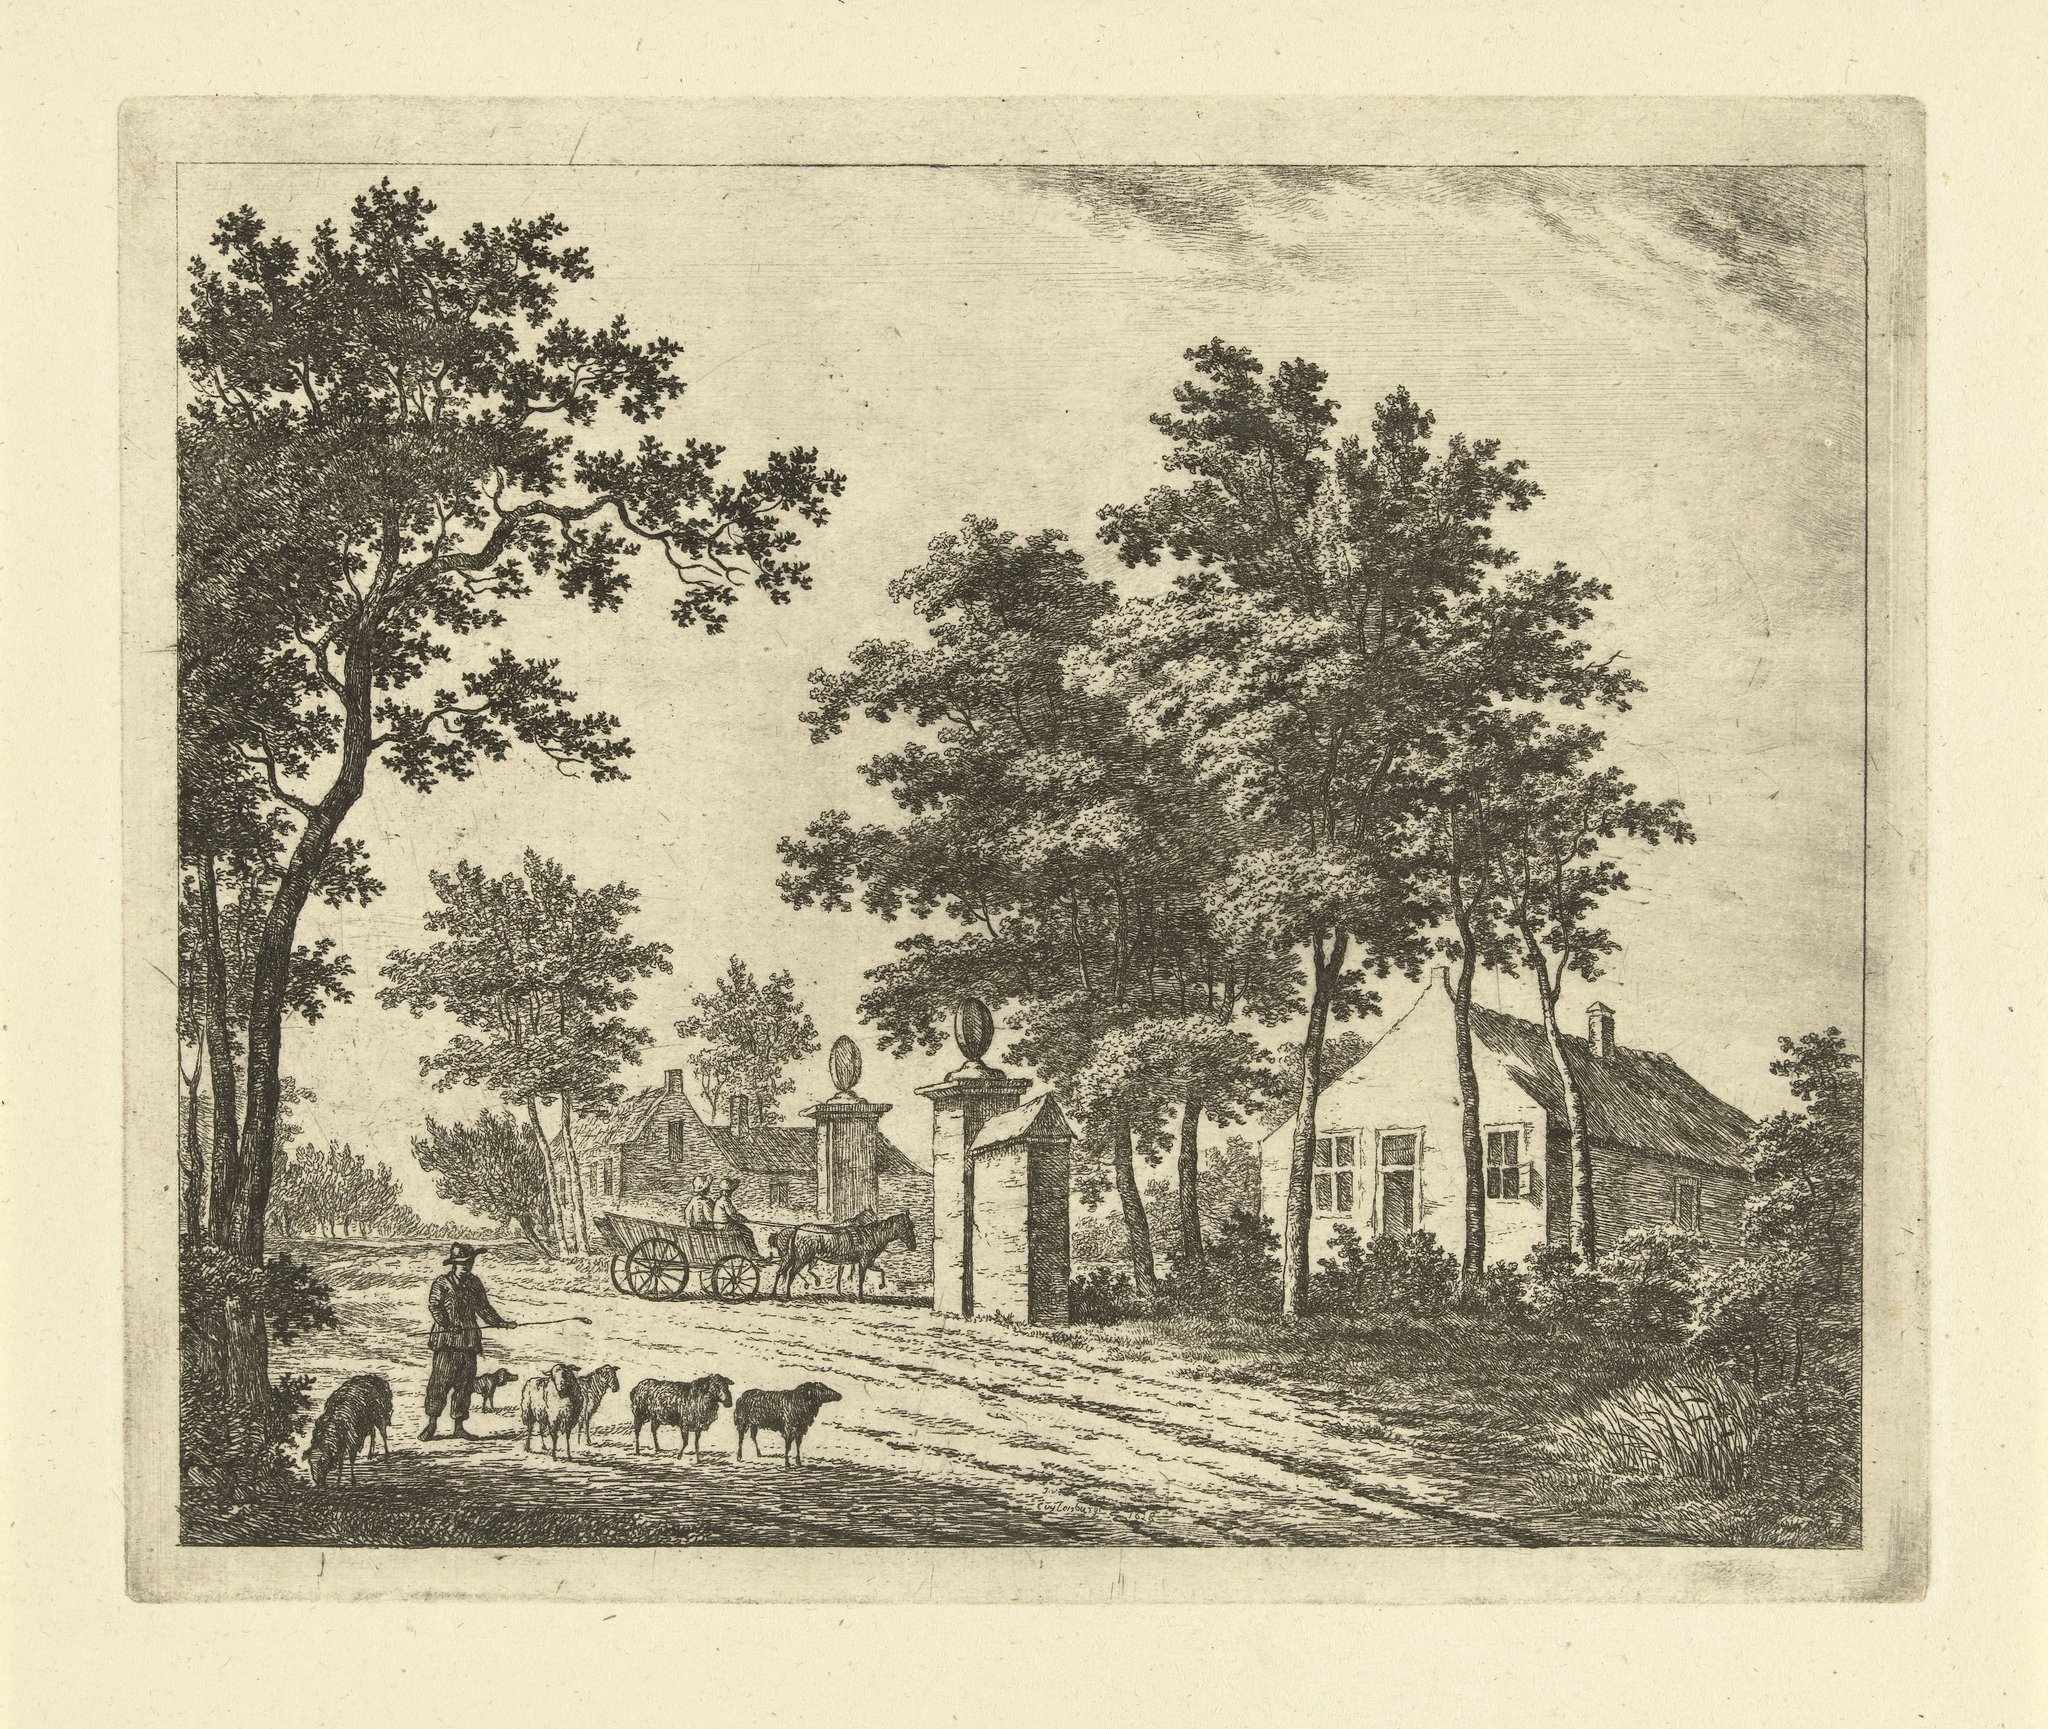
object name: print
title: Landschap met huizen aan landweg en herder met kudde schapen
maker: johannes van cuylenburgh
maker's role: print maker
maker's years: 1793-1841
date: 1828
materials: paper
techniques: etching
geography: netherlands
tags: herding, herdsman, herdswoman, shepherd, shepherdess, cowherd, etc., sheep, farm or solitary house in landscape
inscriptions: collector's mark: Lugt 2228